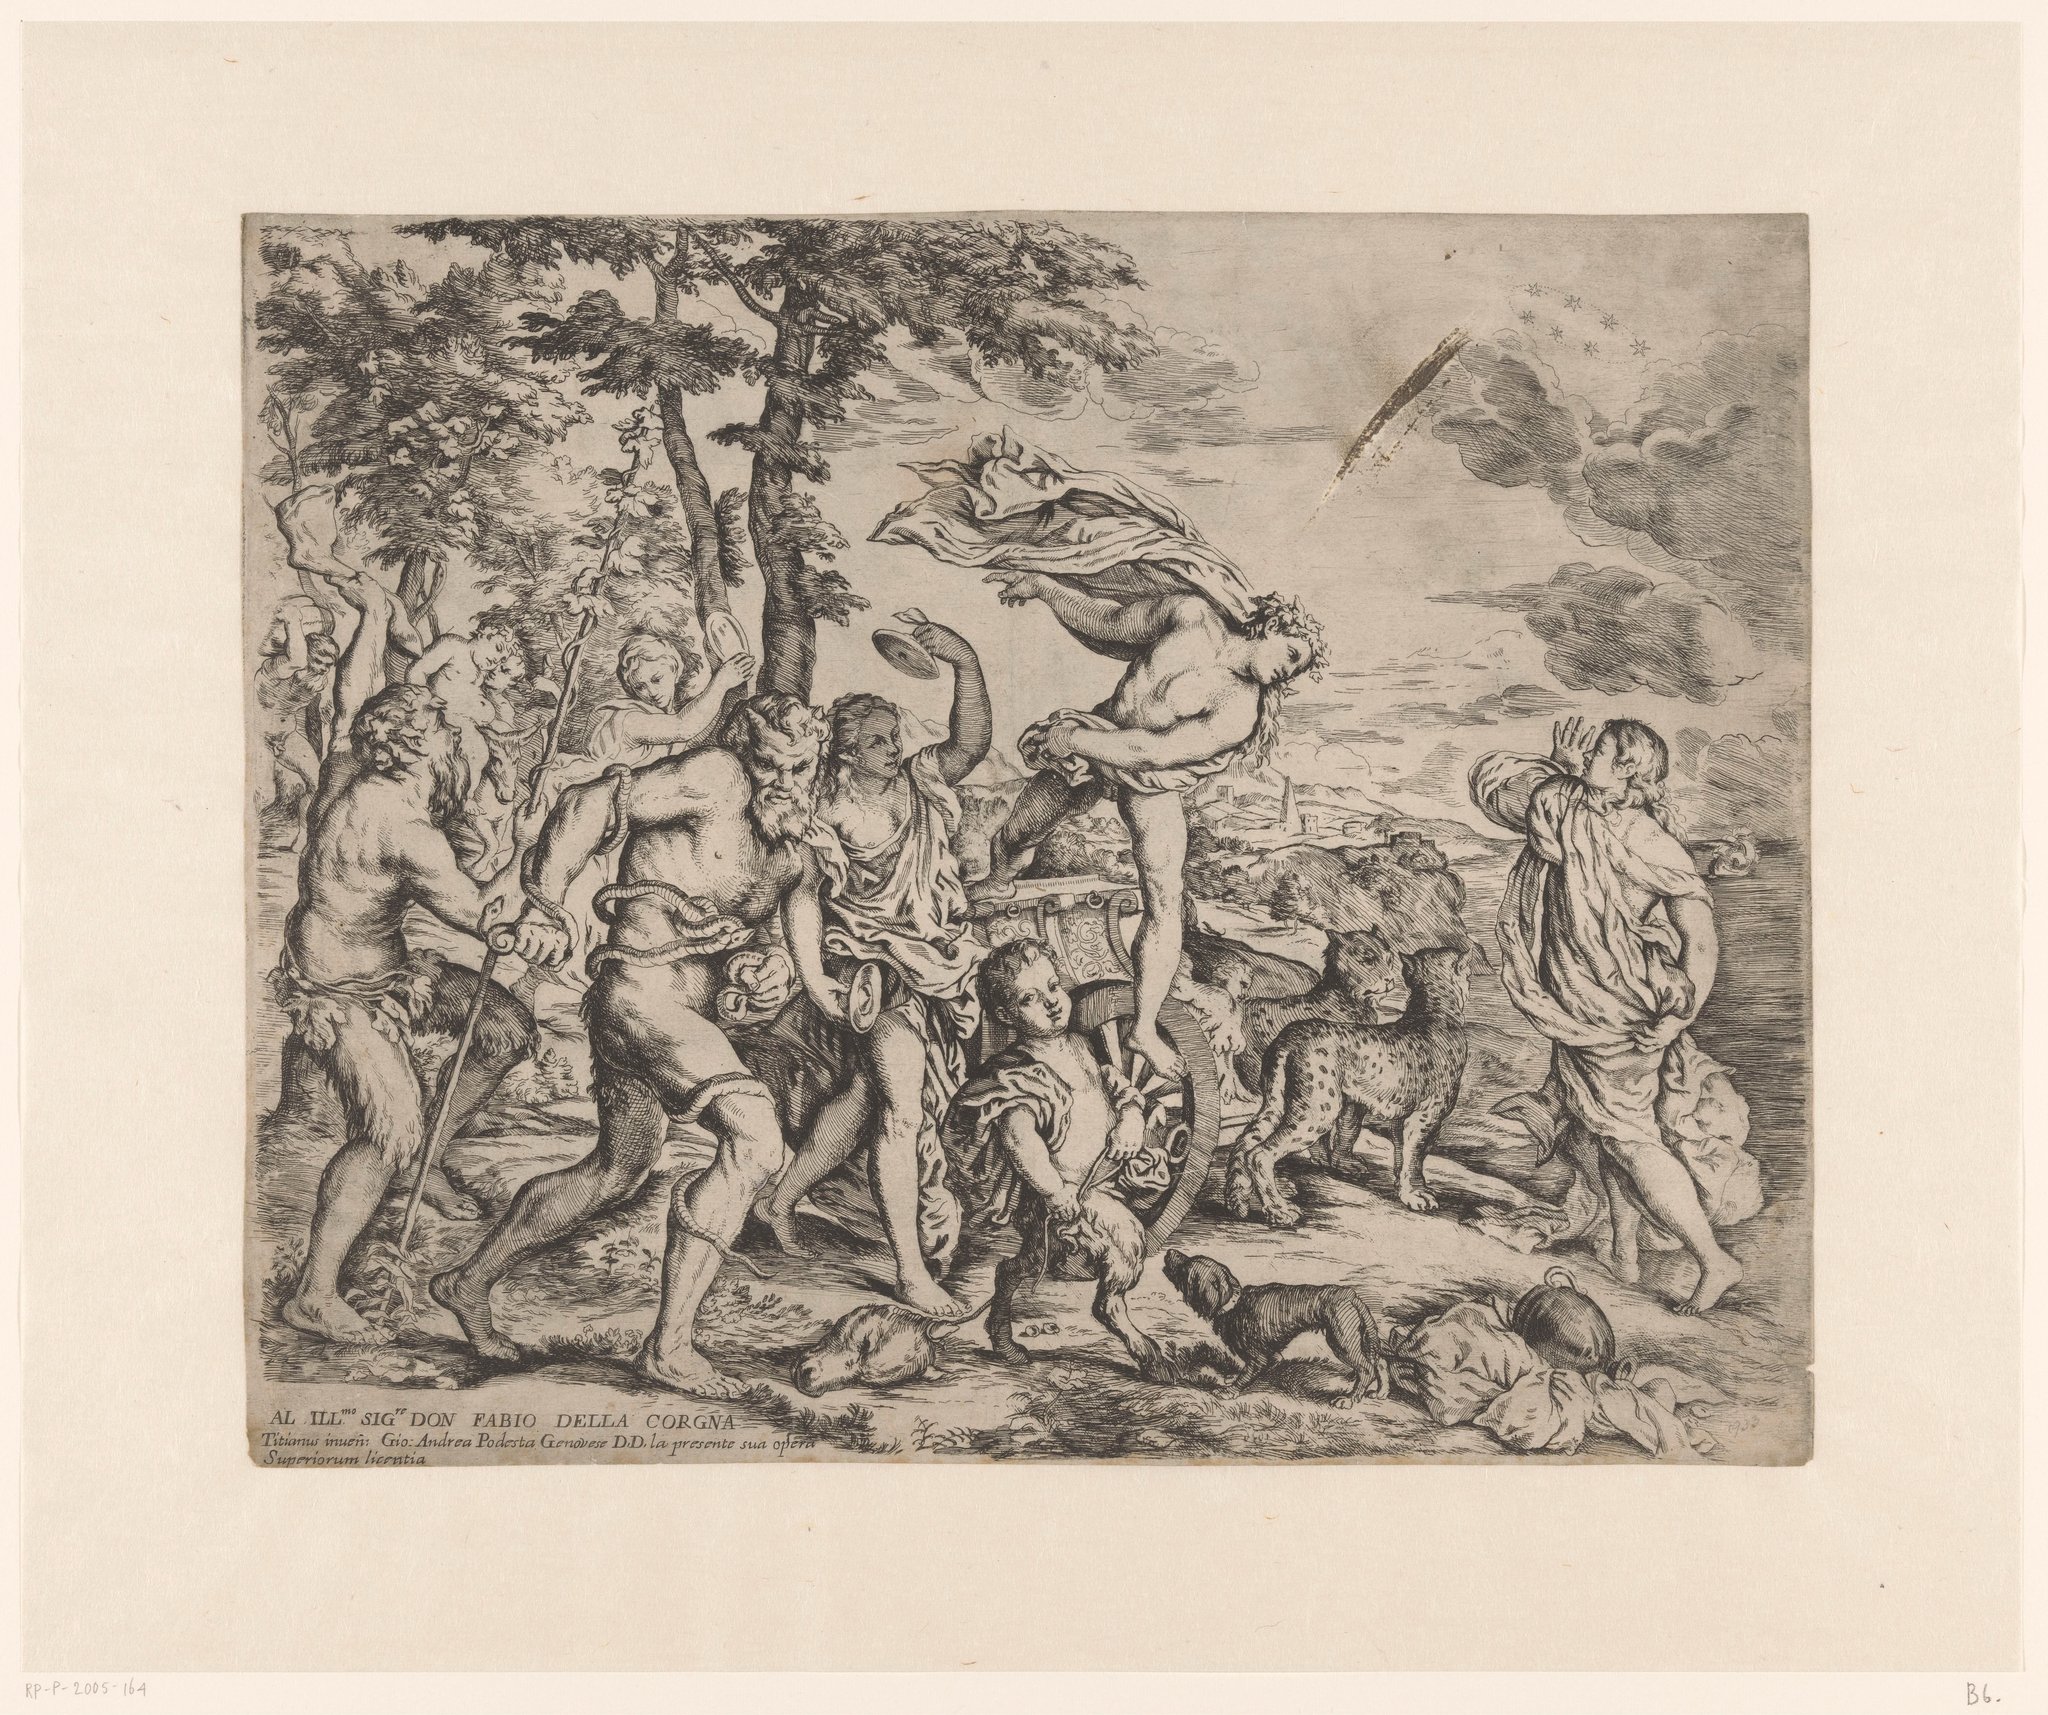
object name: print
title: Bacchus ontmoet Ariadne op Naxos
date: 1618-1674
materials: paper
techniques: etching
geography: genoa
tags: bacchus finds ariadne on naxos, (story of) ariadne and bacchus, bacchanal: bacchus with his wine-flushed train (thiasos)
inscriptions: collector's mark: Lugt 2228, collector's mark: Lugt 2760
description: De originele drukplaat wordt bewaard in de Calcografia Nazionale te Rome (inv.nr. 1051). Naar een schilderij door Titiaan in de National Gallery in Londen.